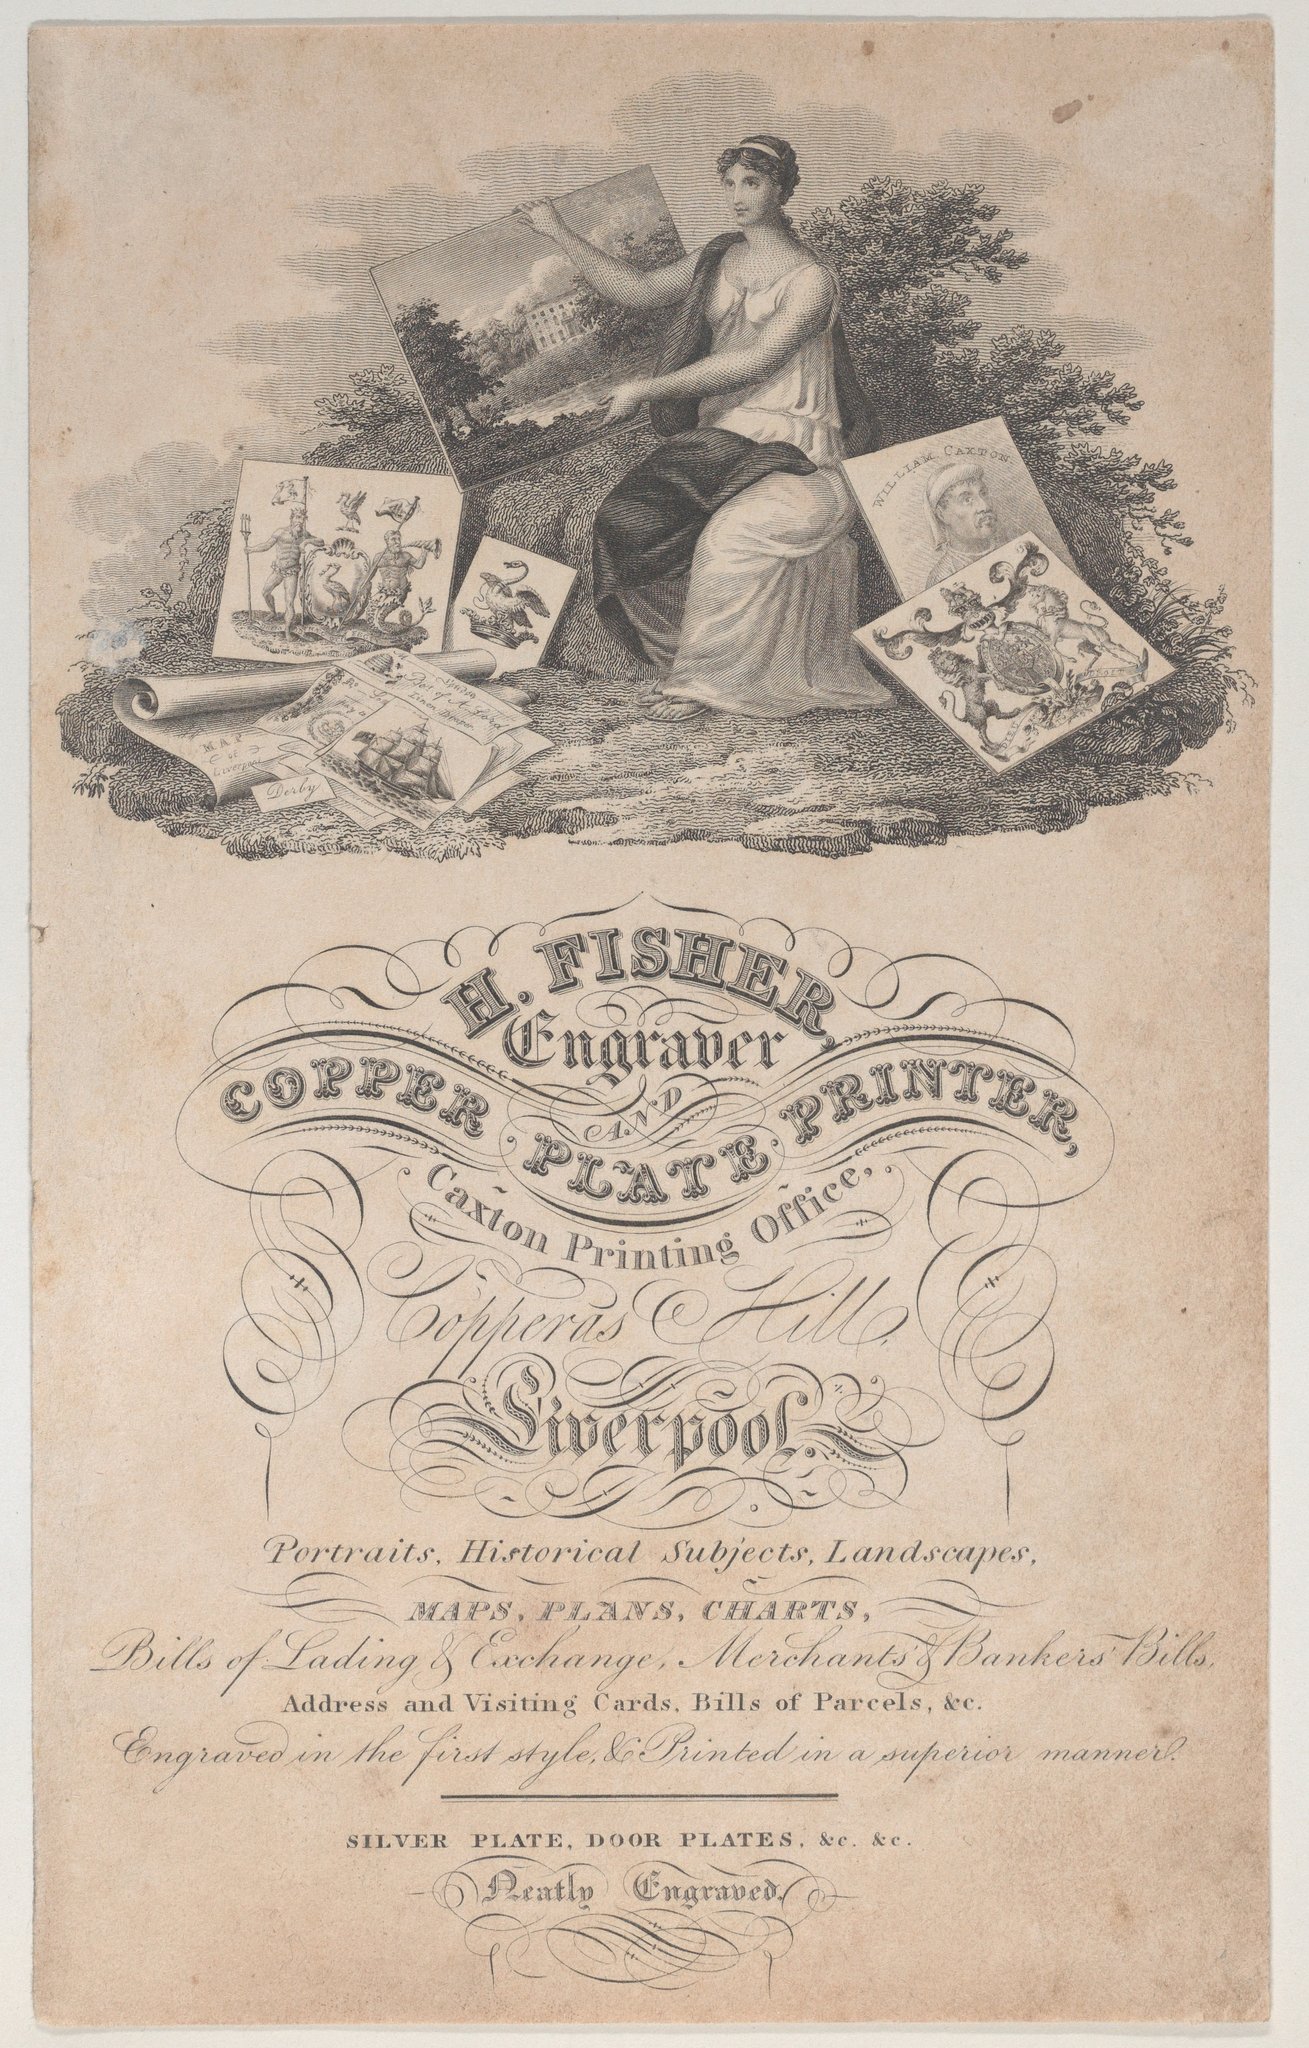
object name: print, trade card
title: Trade Card for H. Fisher, Engraver and Copper Plate Printer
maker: anonymous, british, 18th century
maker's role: artist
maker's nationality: british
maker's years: 1700-1800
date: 1701-1800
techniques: engraving